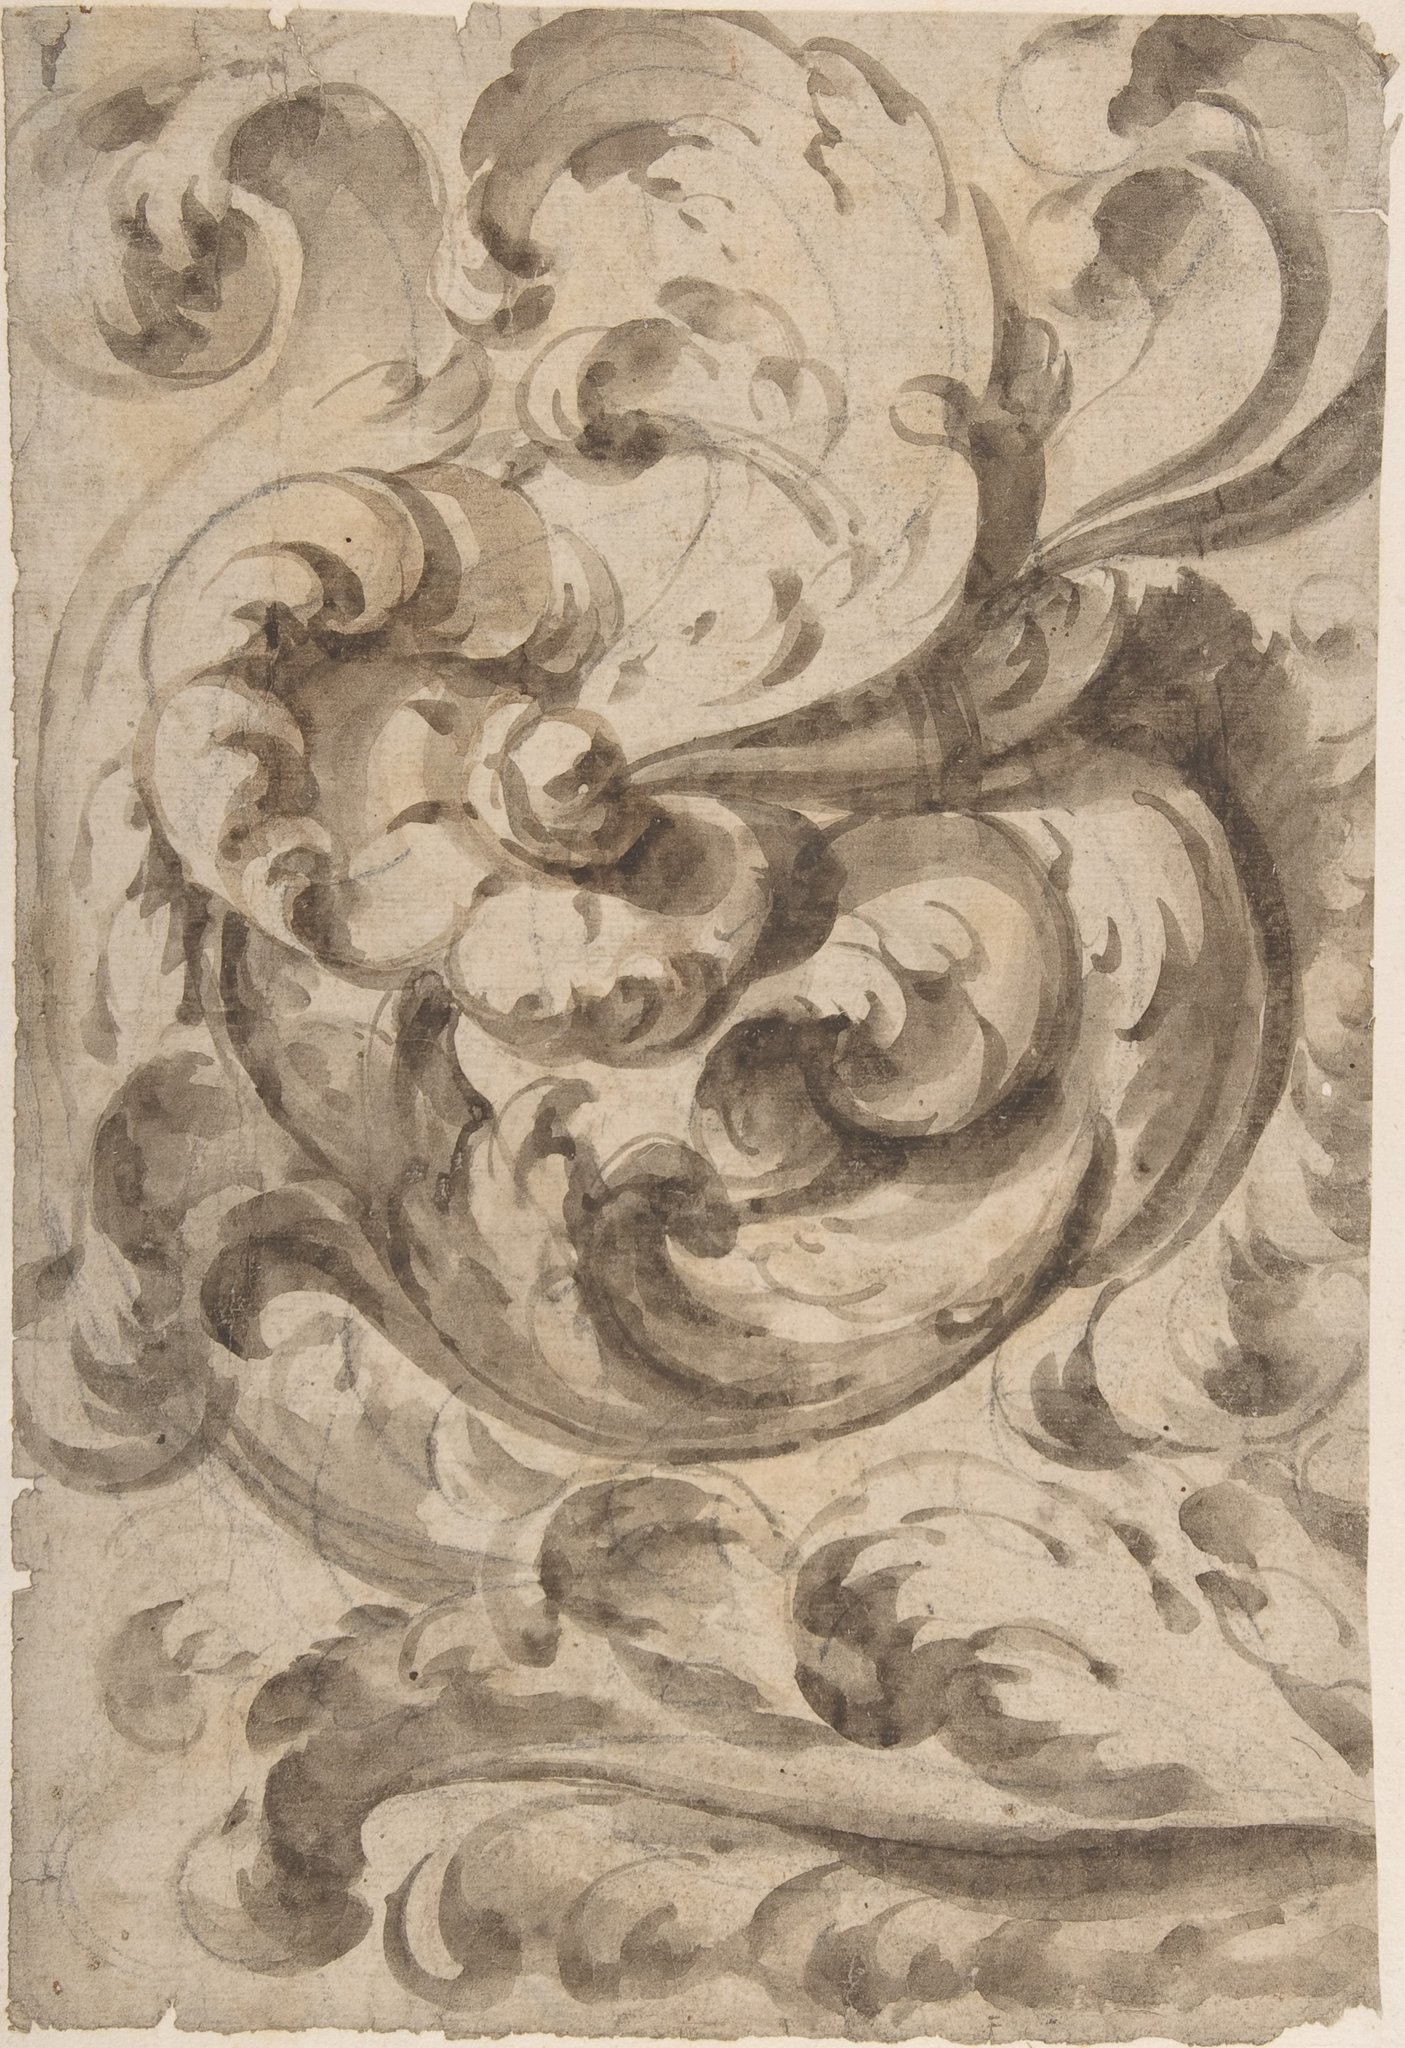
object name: drawing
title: Acanthus Scroll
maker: anonymous, italian, 17th century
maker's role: artist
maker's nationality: italian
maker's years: 1600-1700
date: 1601-1700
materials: graphite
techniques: brush, wash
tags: ornament,acanthus